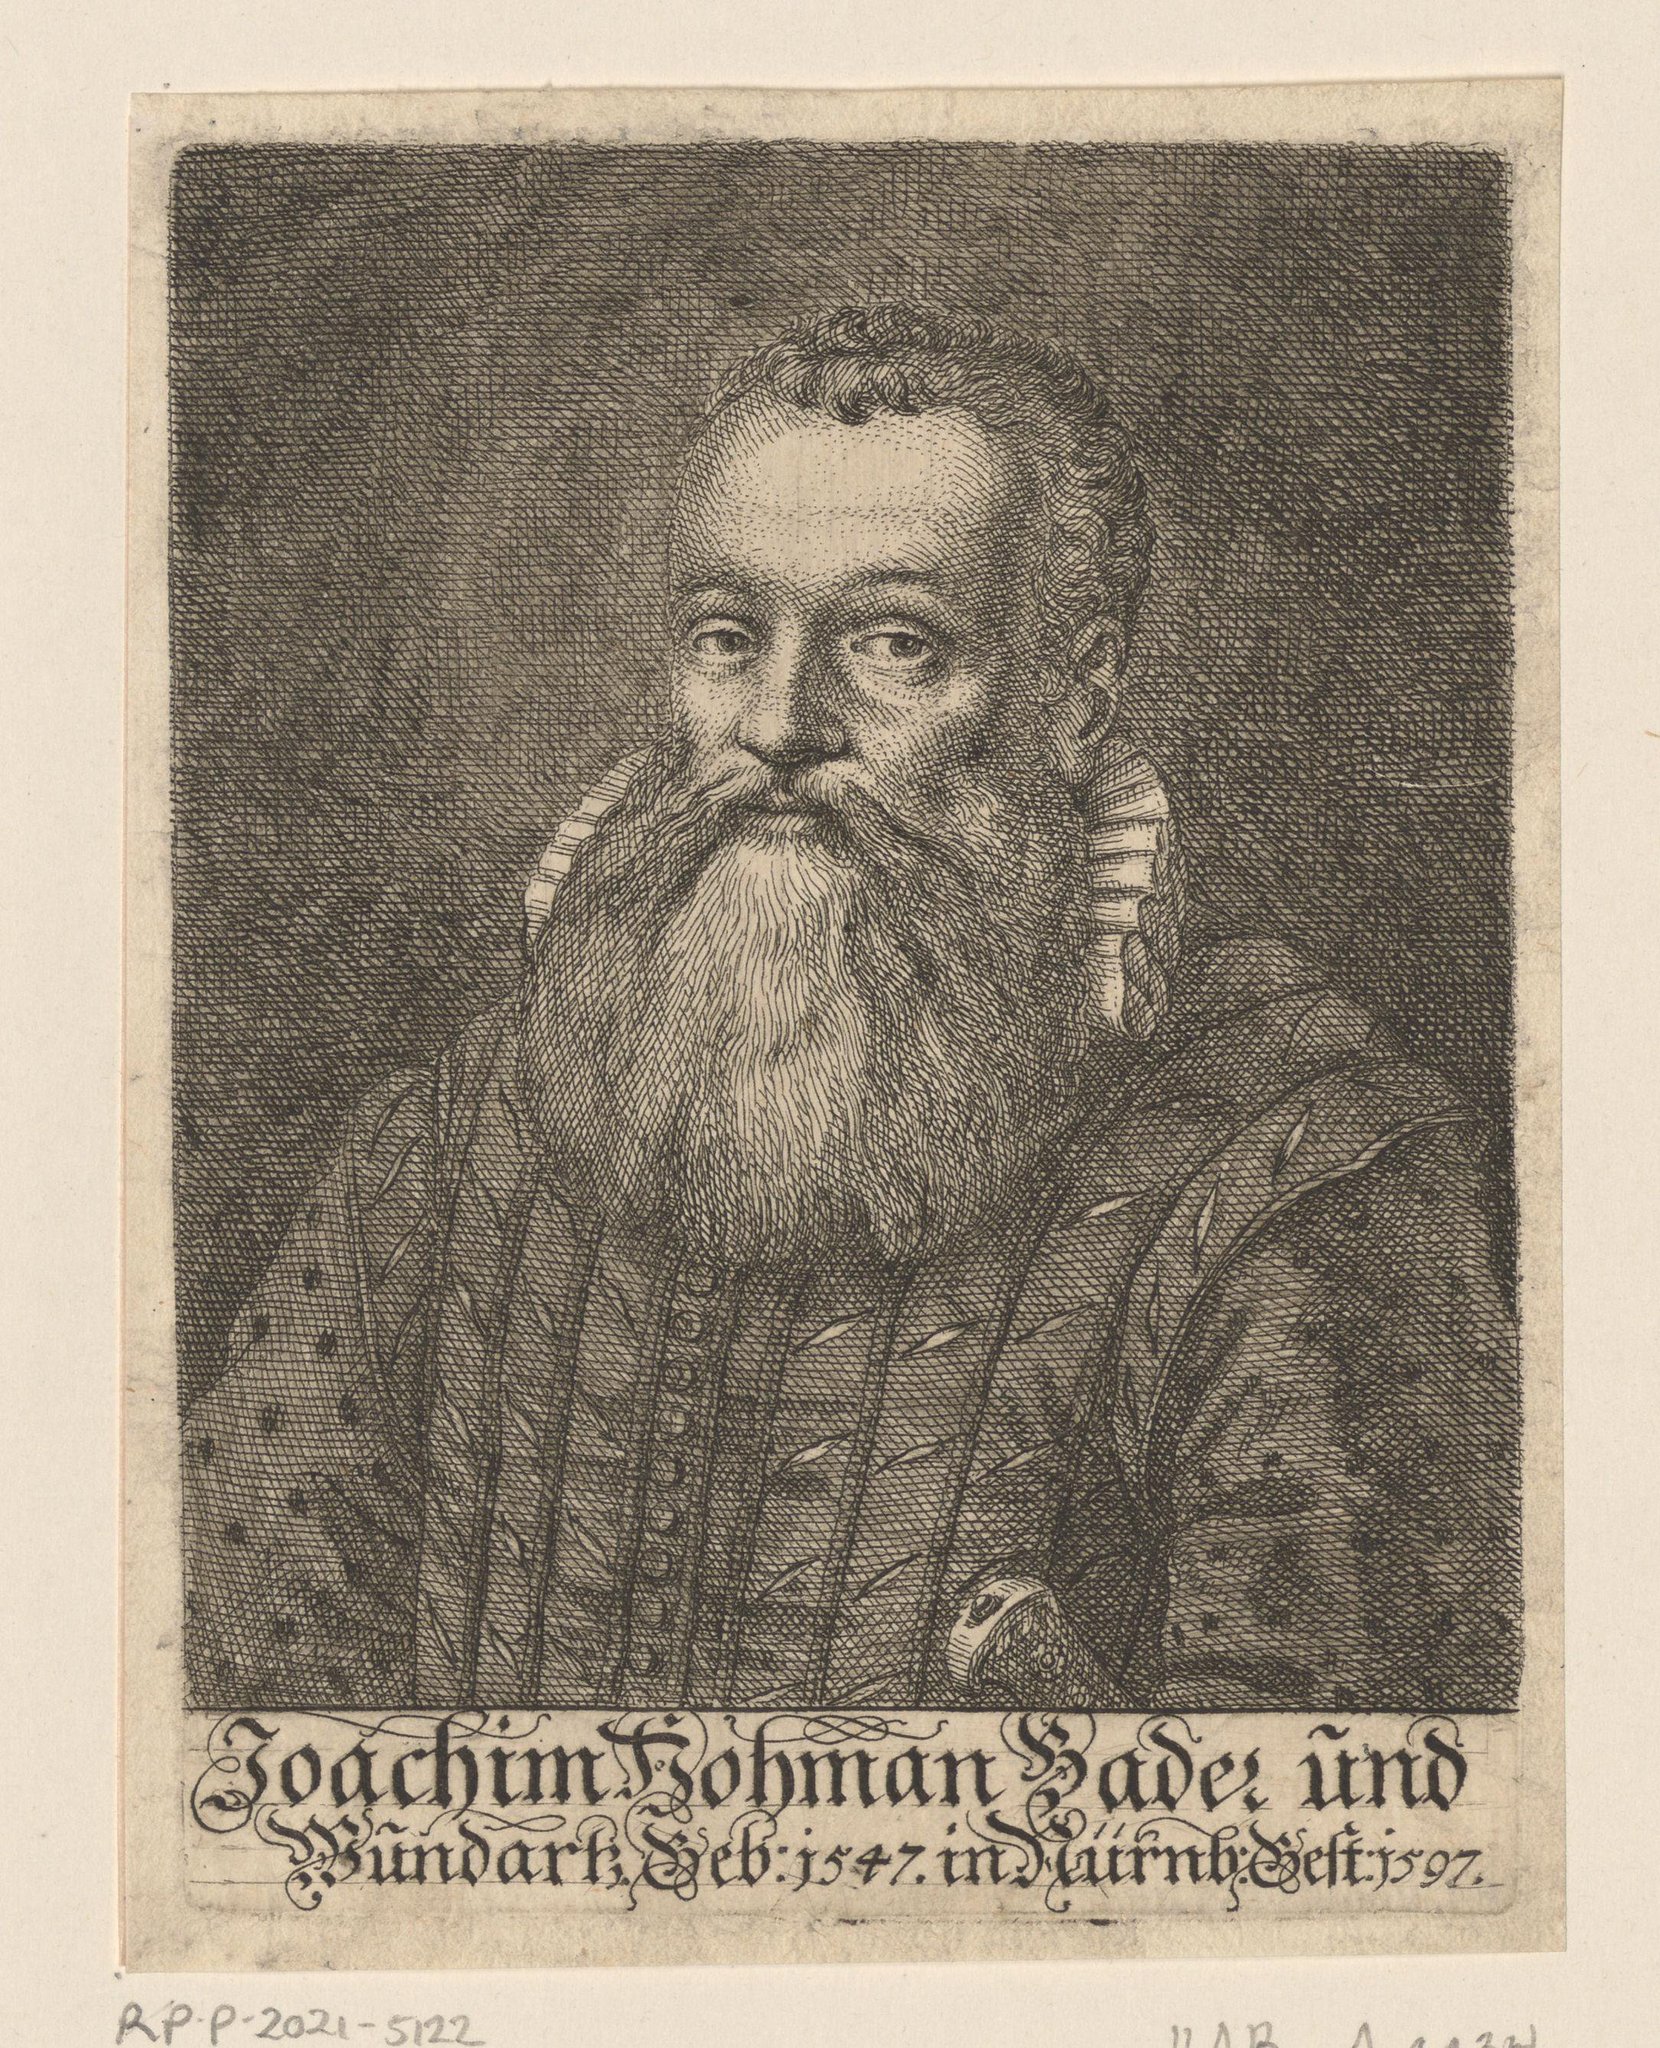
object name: print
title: Portret van Joachim Hohmann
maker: georg strauch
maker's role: print maker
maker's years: 1613-1675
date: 1623-1675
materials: paper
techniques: etching, intaglio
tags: adult man, historical persons, physician, doctor